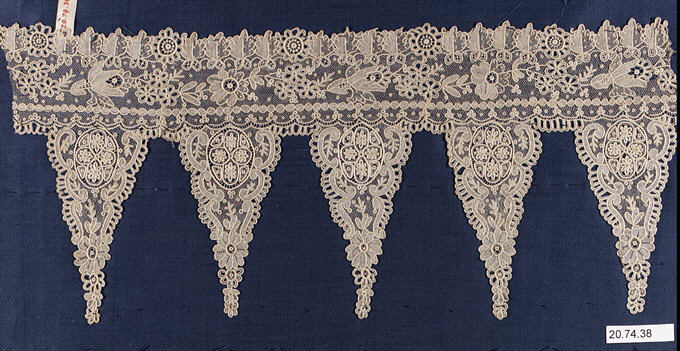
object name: fragment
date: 1801-1900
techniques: lace